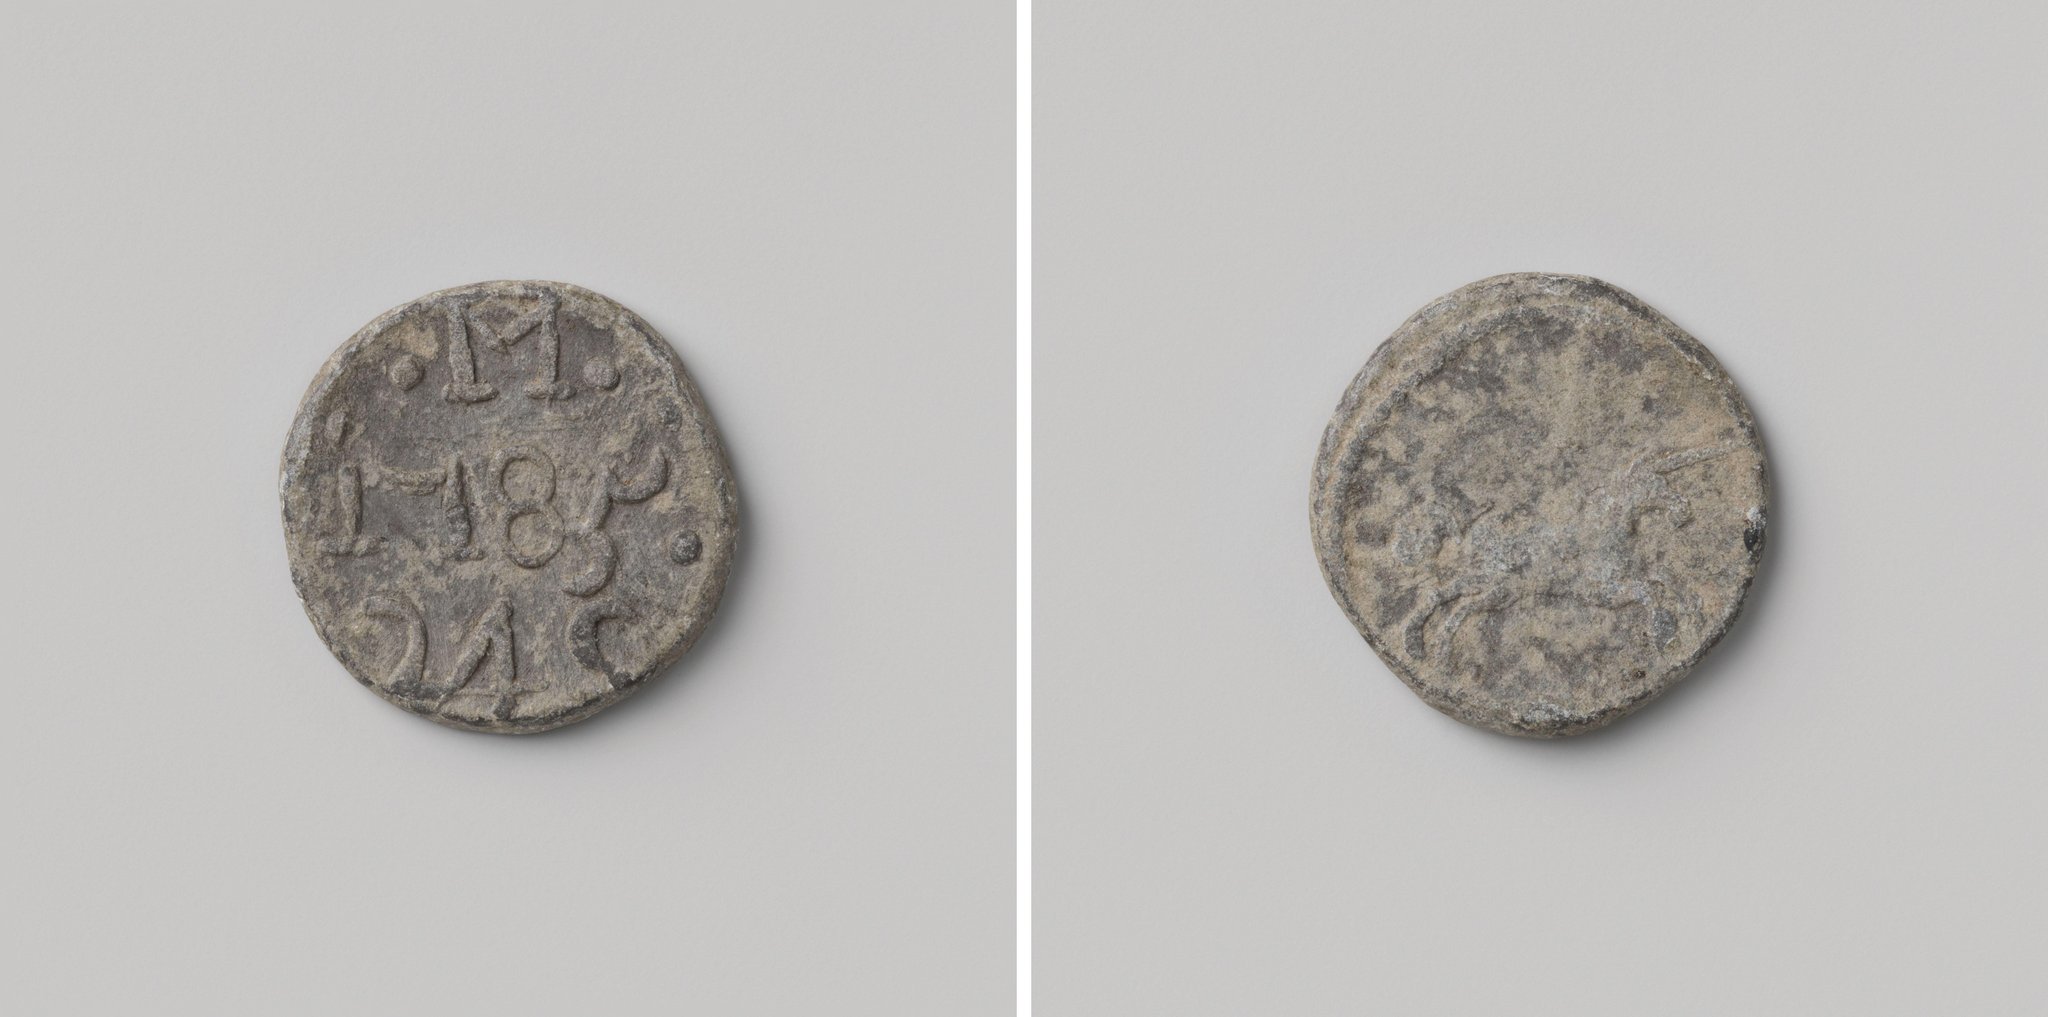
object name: tax token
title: Loden penning voor de Kille (Dordtse Kil) met M 1785 24 S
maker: Anonymous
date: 1785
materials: lead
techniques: striking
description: Voorzijde: opschrift M 1785 24 S. Keerzijde: paard naar rechts